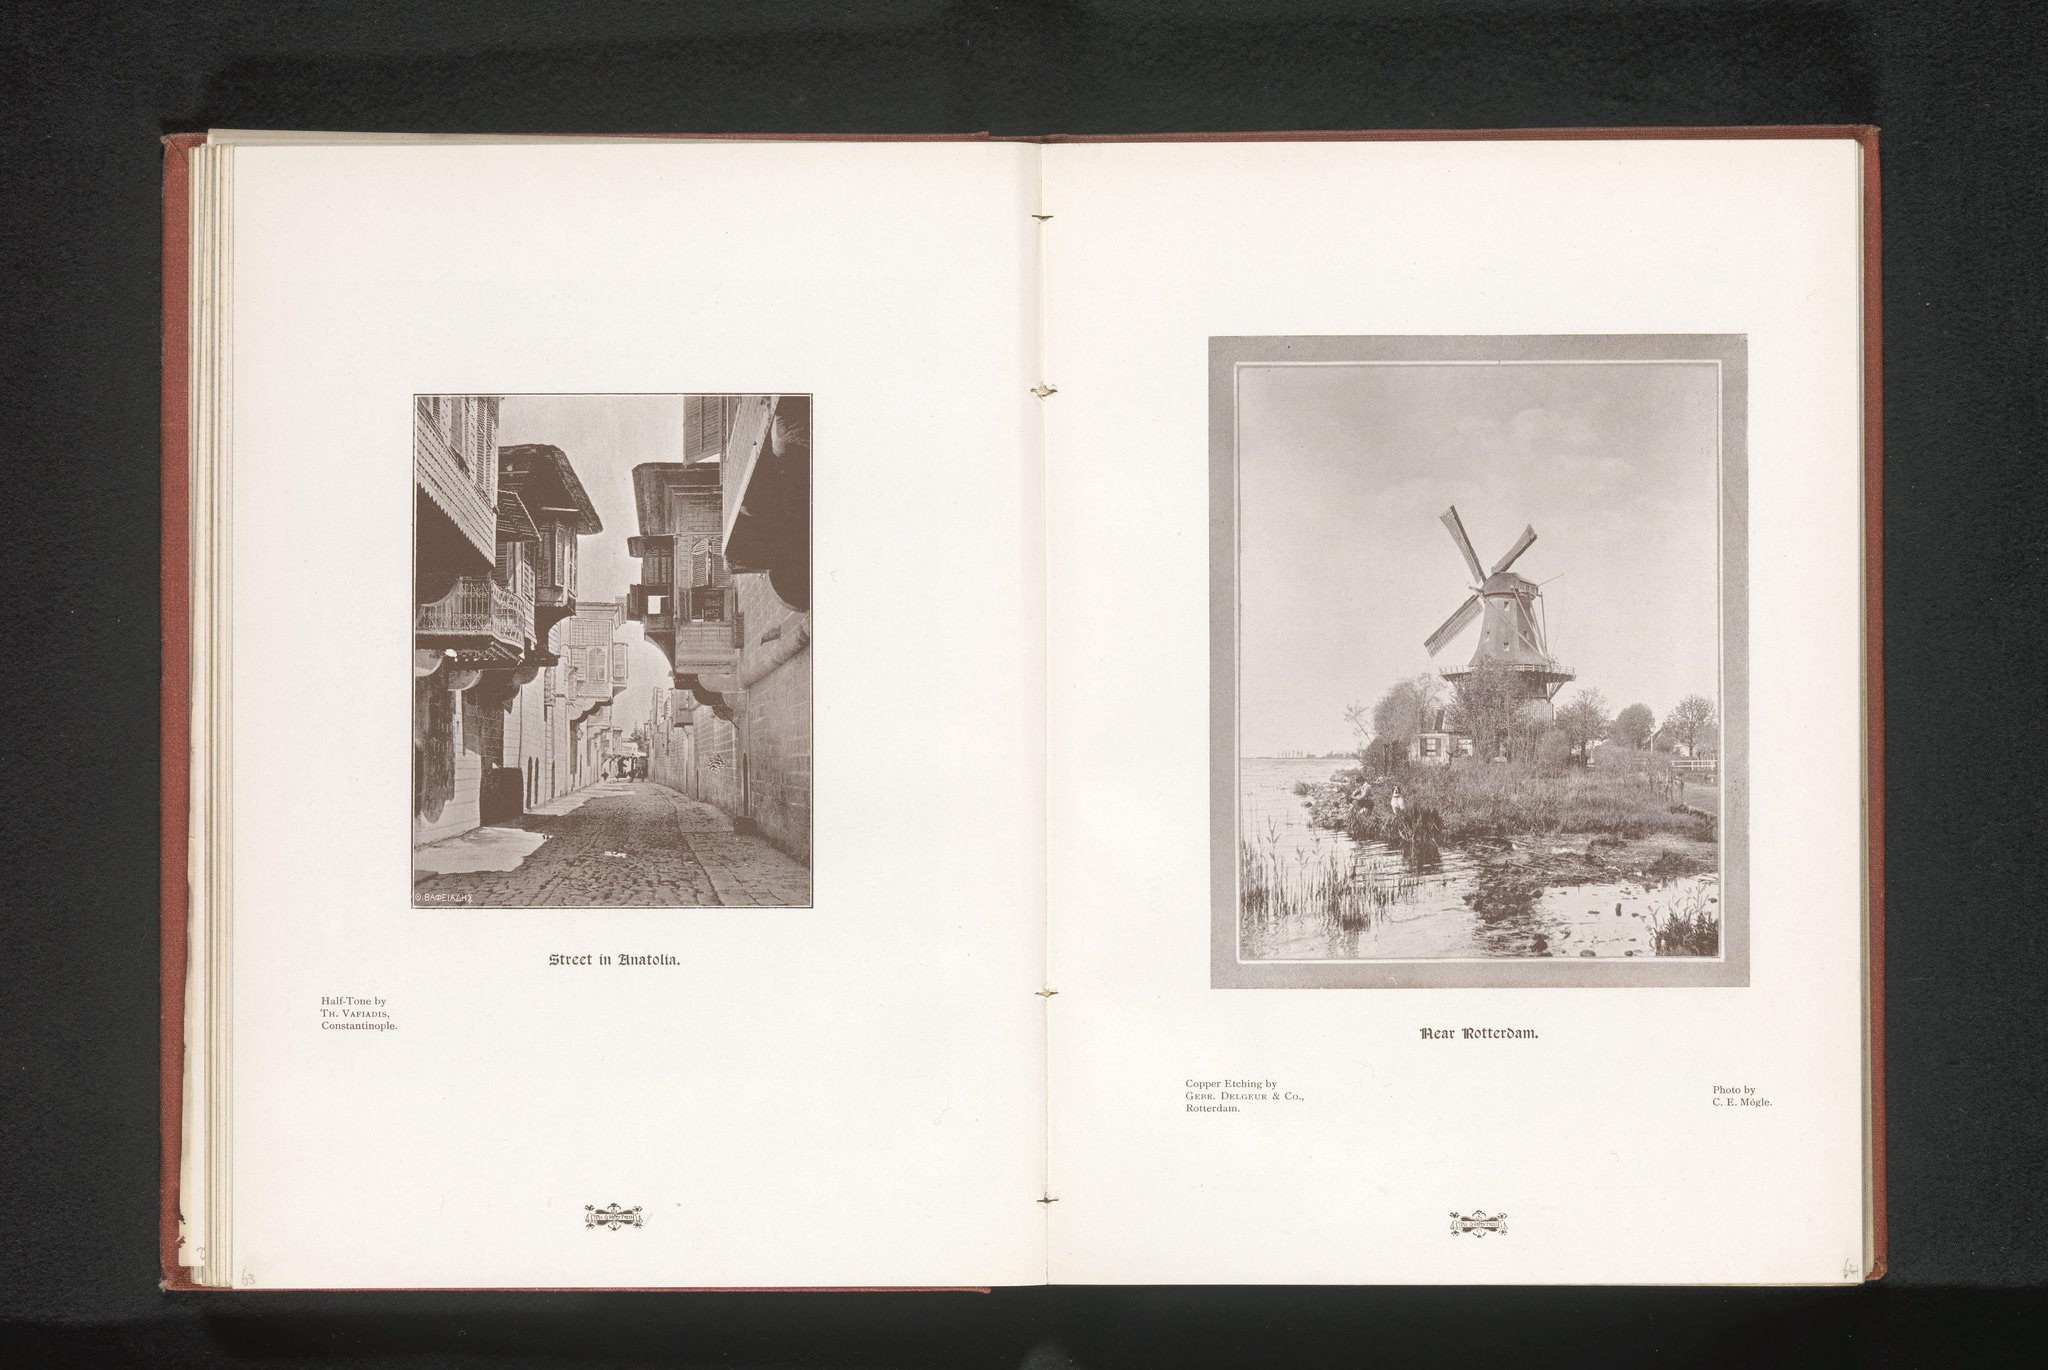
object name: page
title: Straatgezicht in Turkije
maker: theodore vafiadis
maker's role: clichémaker, fotograaf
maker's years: -1922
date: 1895-1900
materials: paper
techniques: autotype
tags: street (+ city(-scape) with figures, staffage)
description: Prent op vierde ongenummerde pagina na pagina 52.